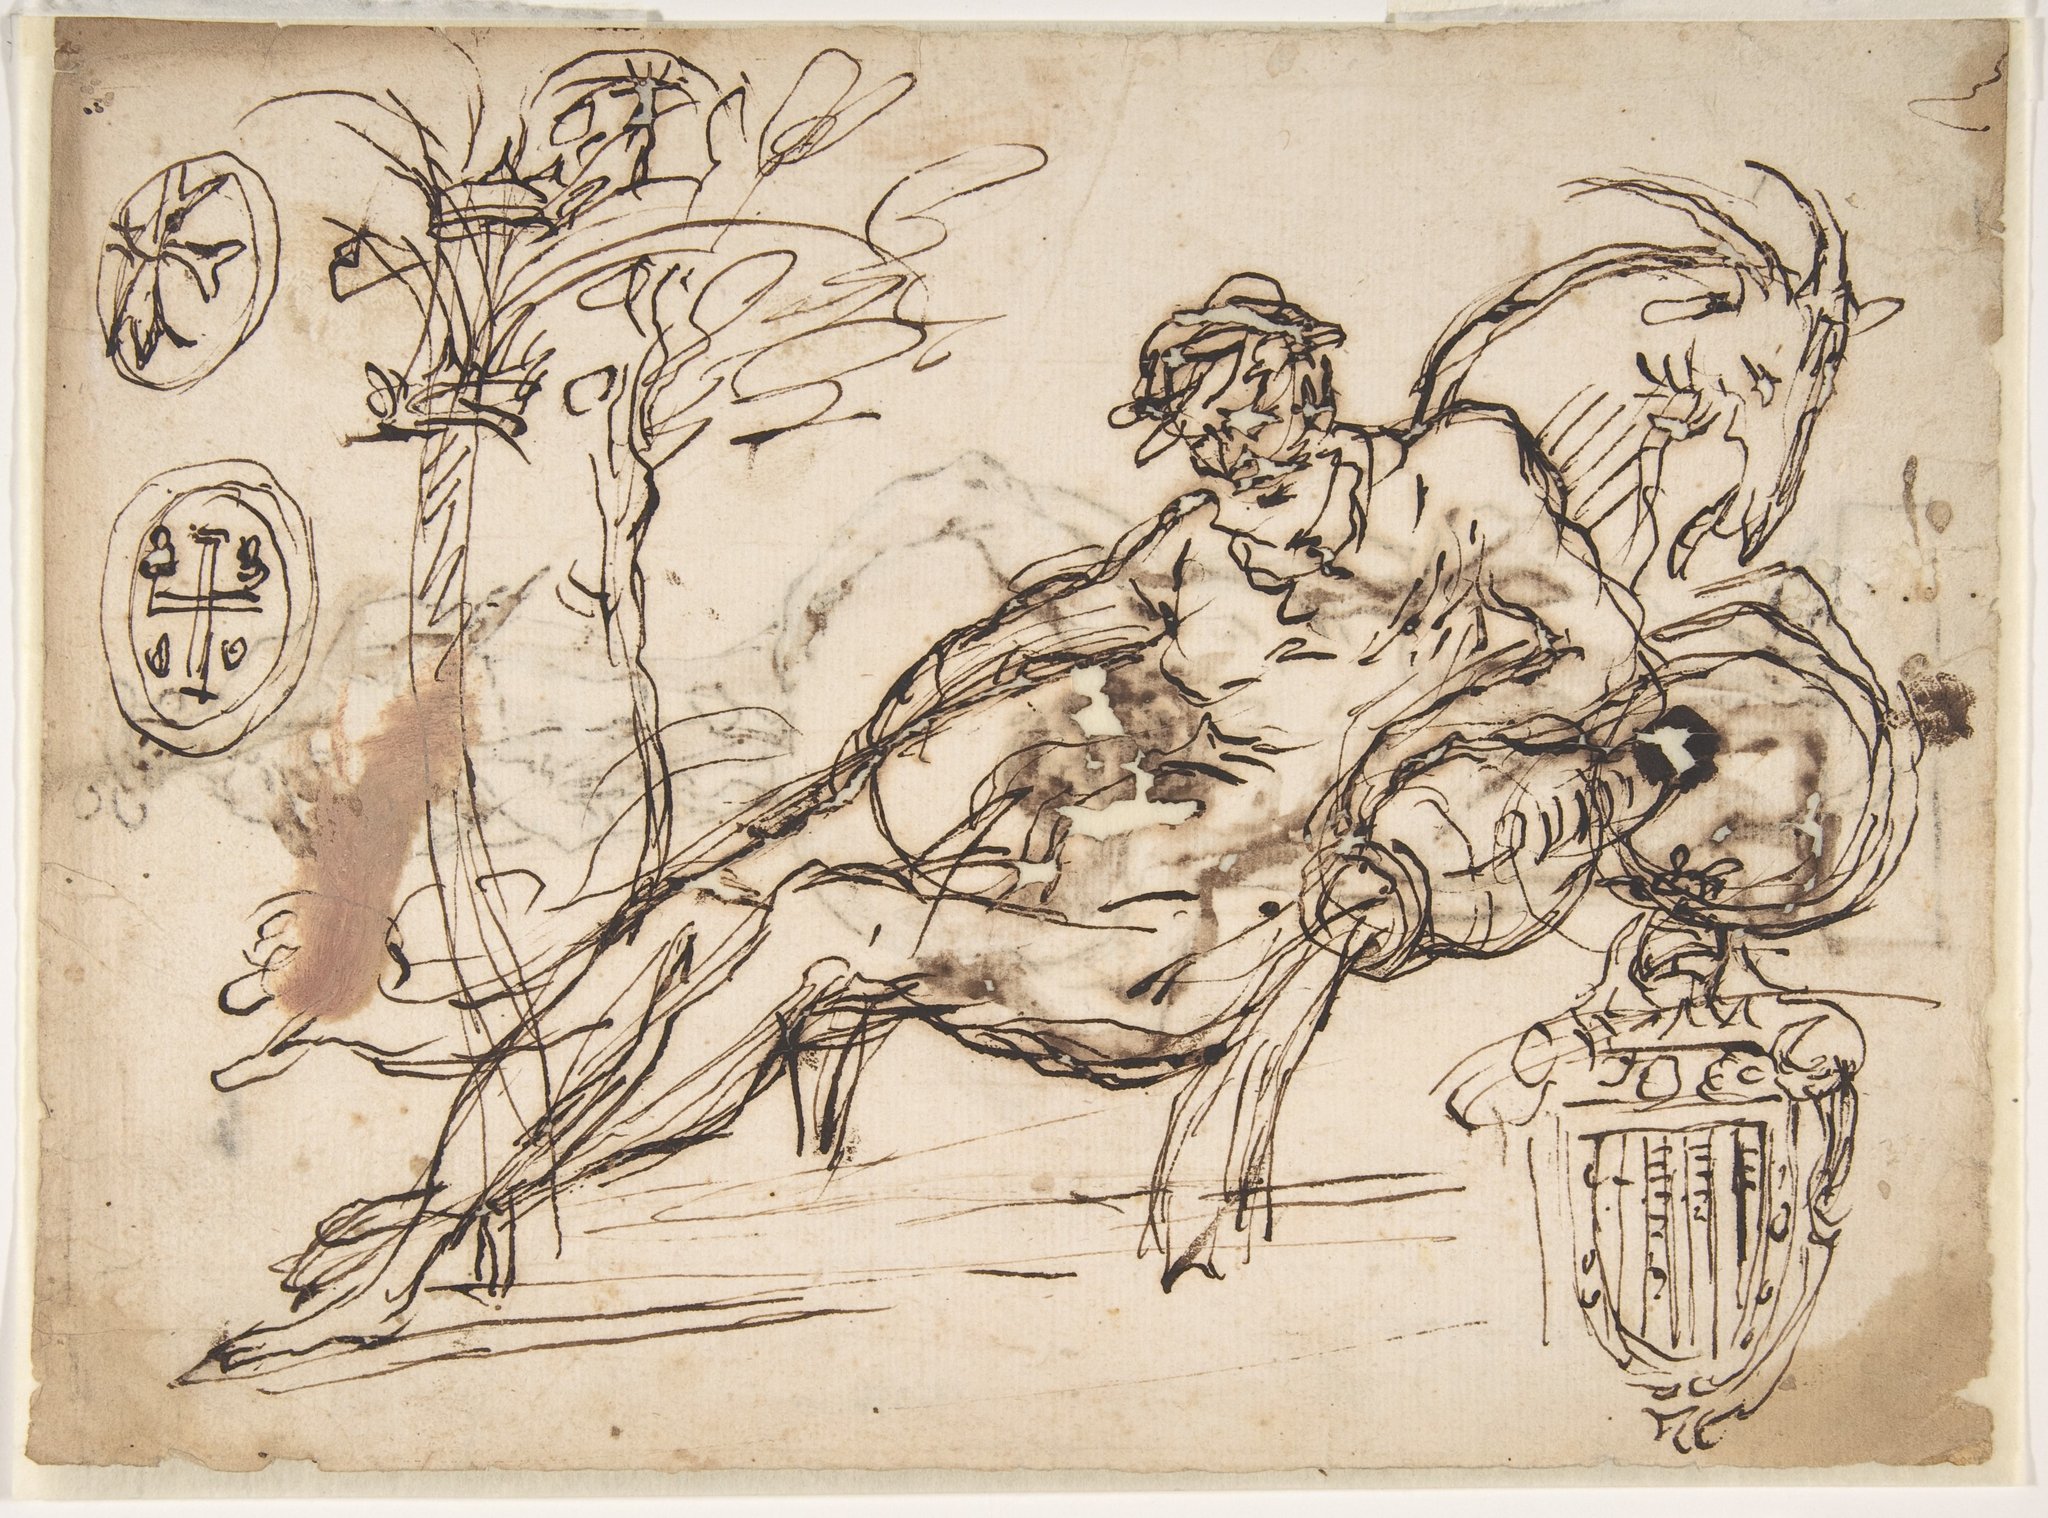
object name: drawing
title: Reclining River God, a Goat's Head, and Studies of Heraldic Emblems (recto); Cavalier Standing on a Globe Supported by a Kneeling Giant (verso)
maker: micco spadaro (domenico gargiulo)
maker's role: artist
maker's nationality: italian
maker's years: 1609-1675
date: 1612-1675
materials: ink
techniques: drawing, lining, pen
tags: men,goats